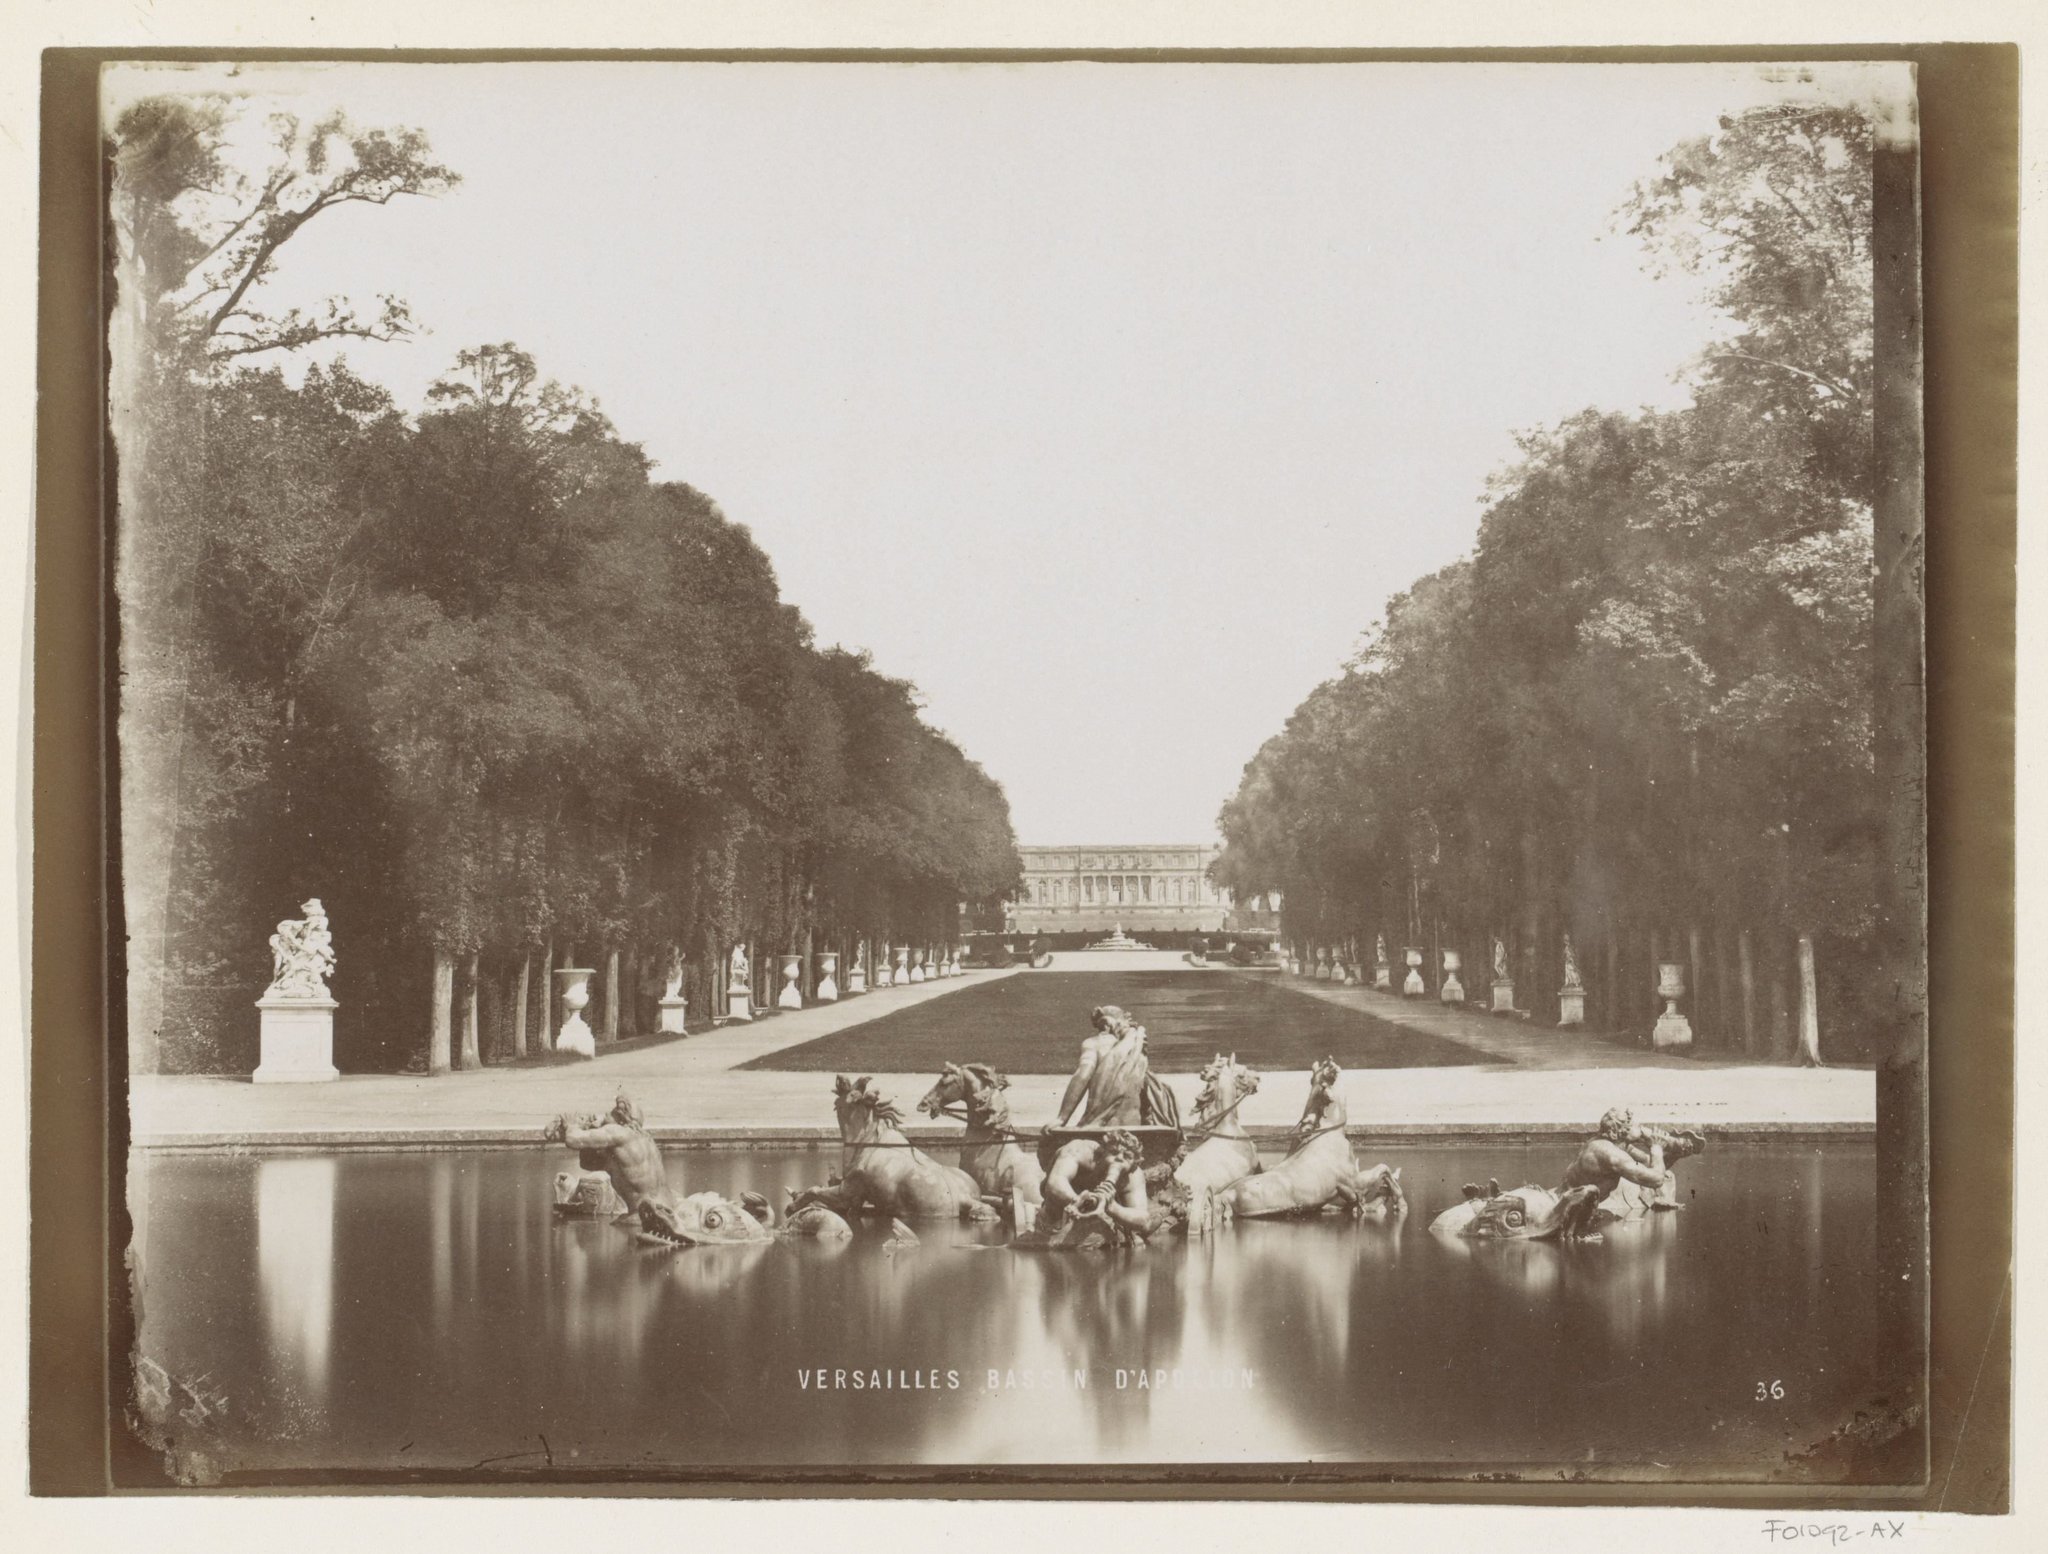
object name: photograph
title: Apollovijver bij het Paleis van Versailles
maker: Anonymous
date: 1880-1900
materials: cardboard, paper, photographic support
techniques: albumen print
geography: versailles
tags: piece of sculpture, reproduction of a piece of sculpture (+ sculpture), ornamental fountain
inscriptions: negative number: ‘36’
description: Onderdeel van Reisalbum met foto's van bezienswaardigheden in België en Frankrijk.